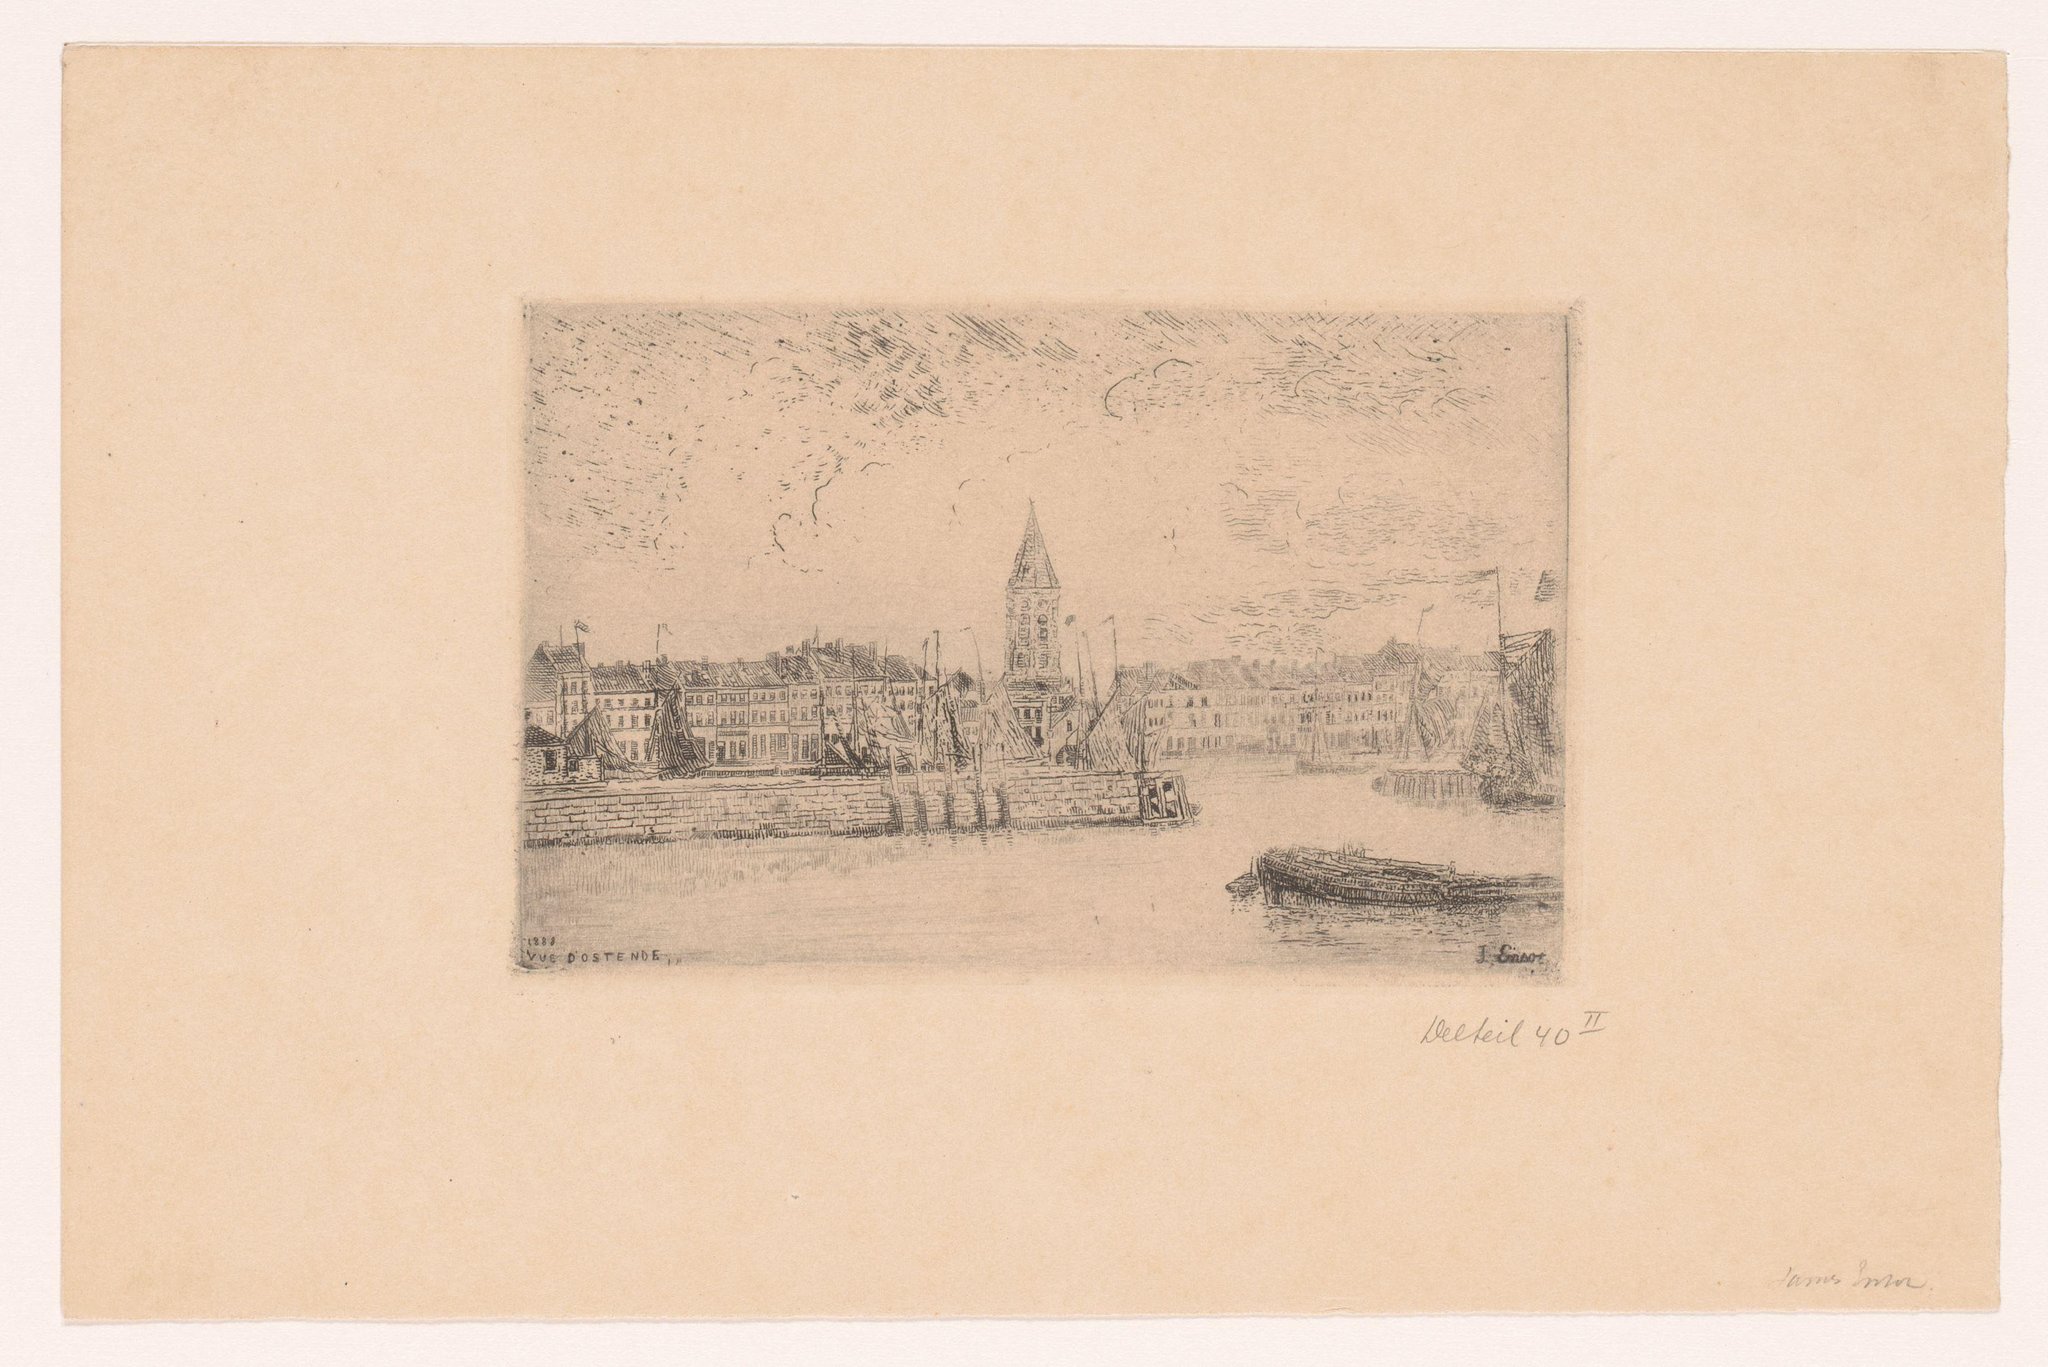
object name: print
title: Vue d'Ostende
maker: james ensor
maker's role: print maker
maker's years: 1860-1949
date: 1888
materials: paper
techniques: etching, intaglio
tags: pier, quay, wharf, prospect of city, town panorama, silhouette of city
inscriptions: collector's mark: Lugt 2228